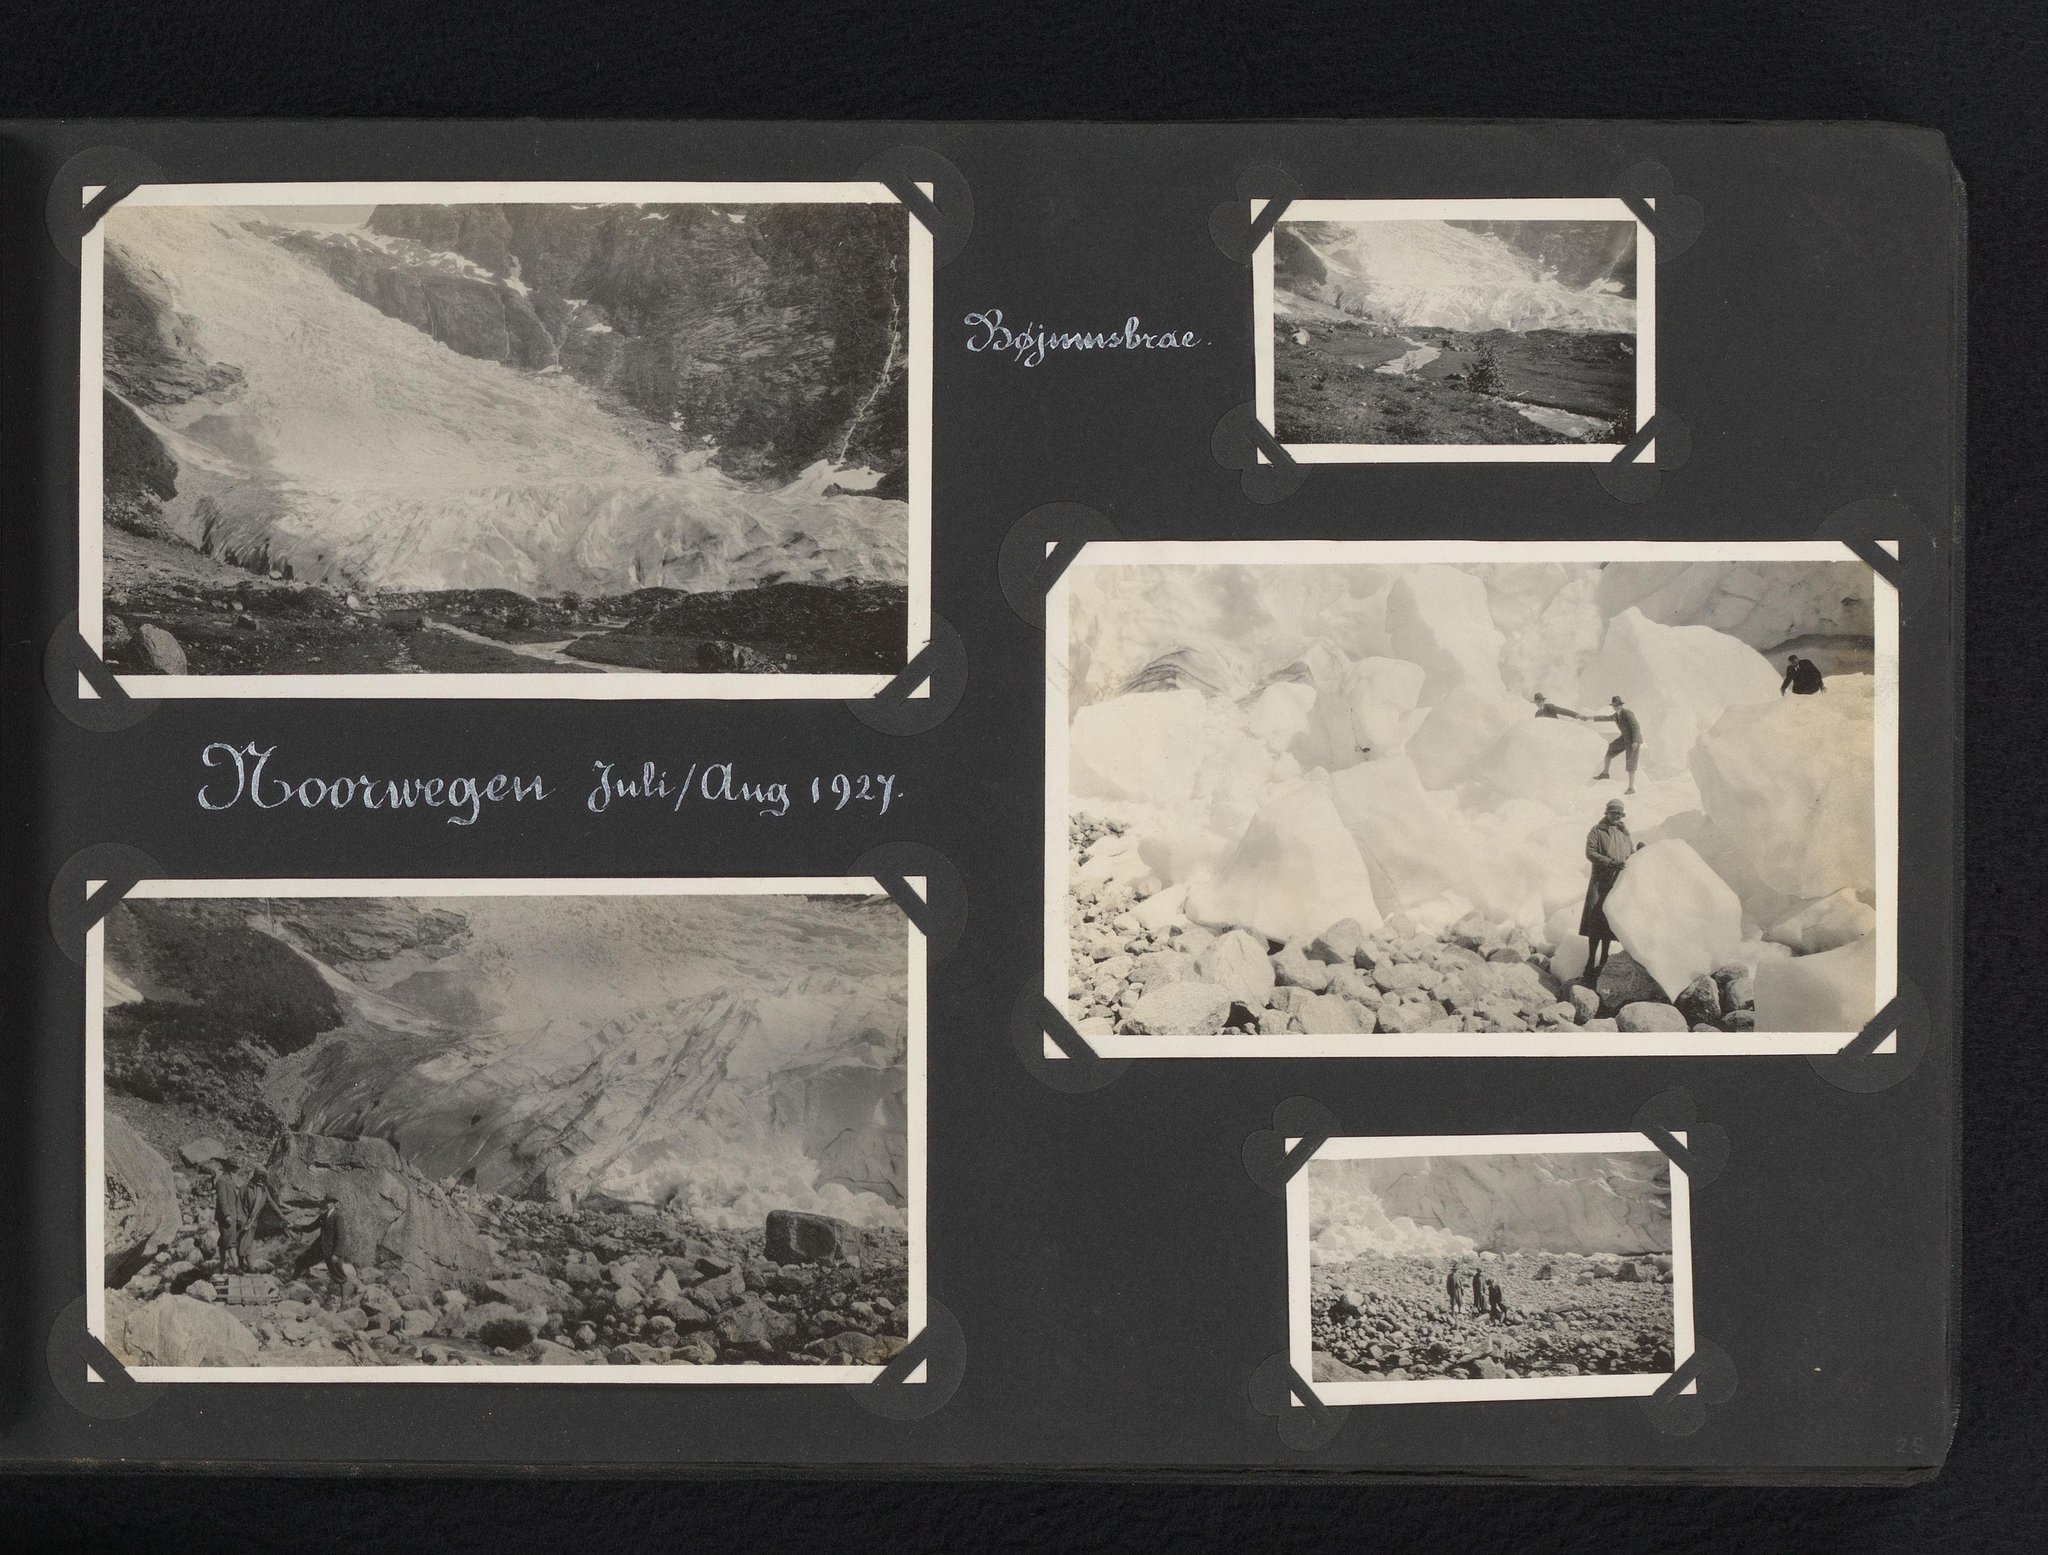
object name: ansichtkaart, prentbriefkaart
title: Vijf foto's van een gletsjer nabij Fjærland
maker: hendrik herman van den berg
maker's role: amateurfotograaf, jurist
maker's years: 1875-1944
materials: paper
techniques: gelatin silver print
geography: fjærland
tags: the hague, caroline louise van den berg-van den berg, carel frederik van den berg (cay), frank willem van den berg (1912-1998), glacier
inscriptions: inscription: ‘Bojunnsbrae’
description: Deze foto's maken deel uit van een album.